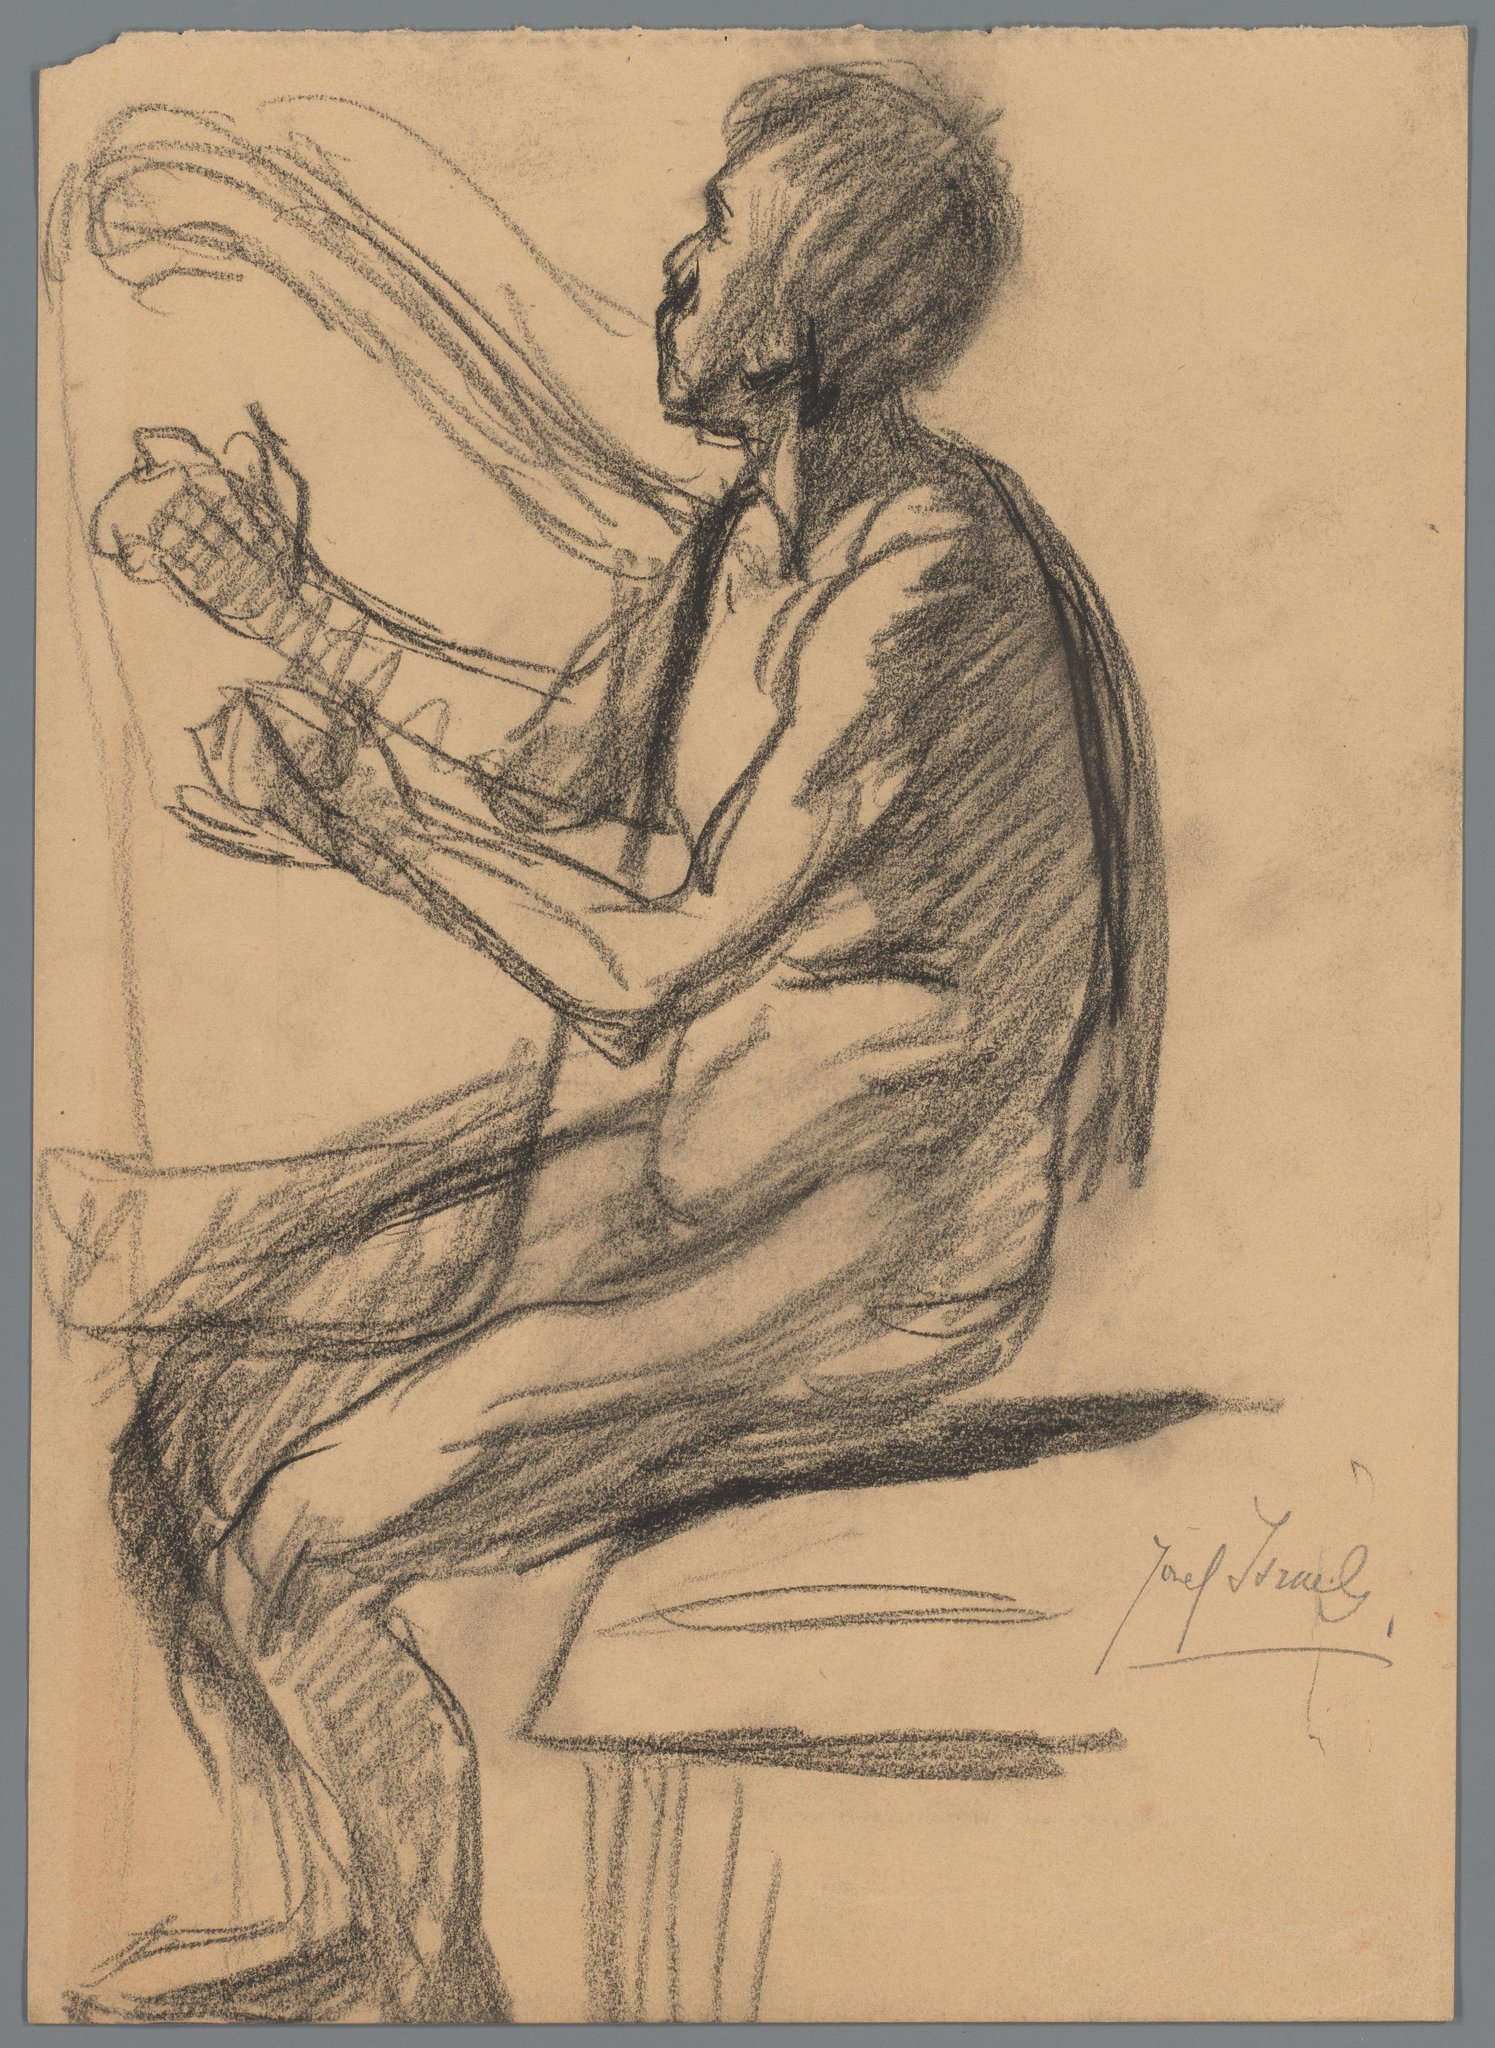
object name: drawing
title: Harpspelende David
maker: jozef israëls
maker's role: draughtsman, painter, print maker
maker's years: 1824-1911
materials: chalk, paper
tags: david as musician, usually playing the harp, harp (+ artist at work)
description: Voorstudie voor het schilderij 'David en Saul' dat zich in het Groninger Museum bevindt.